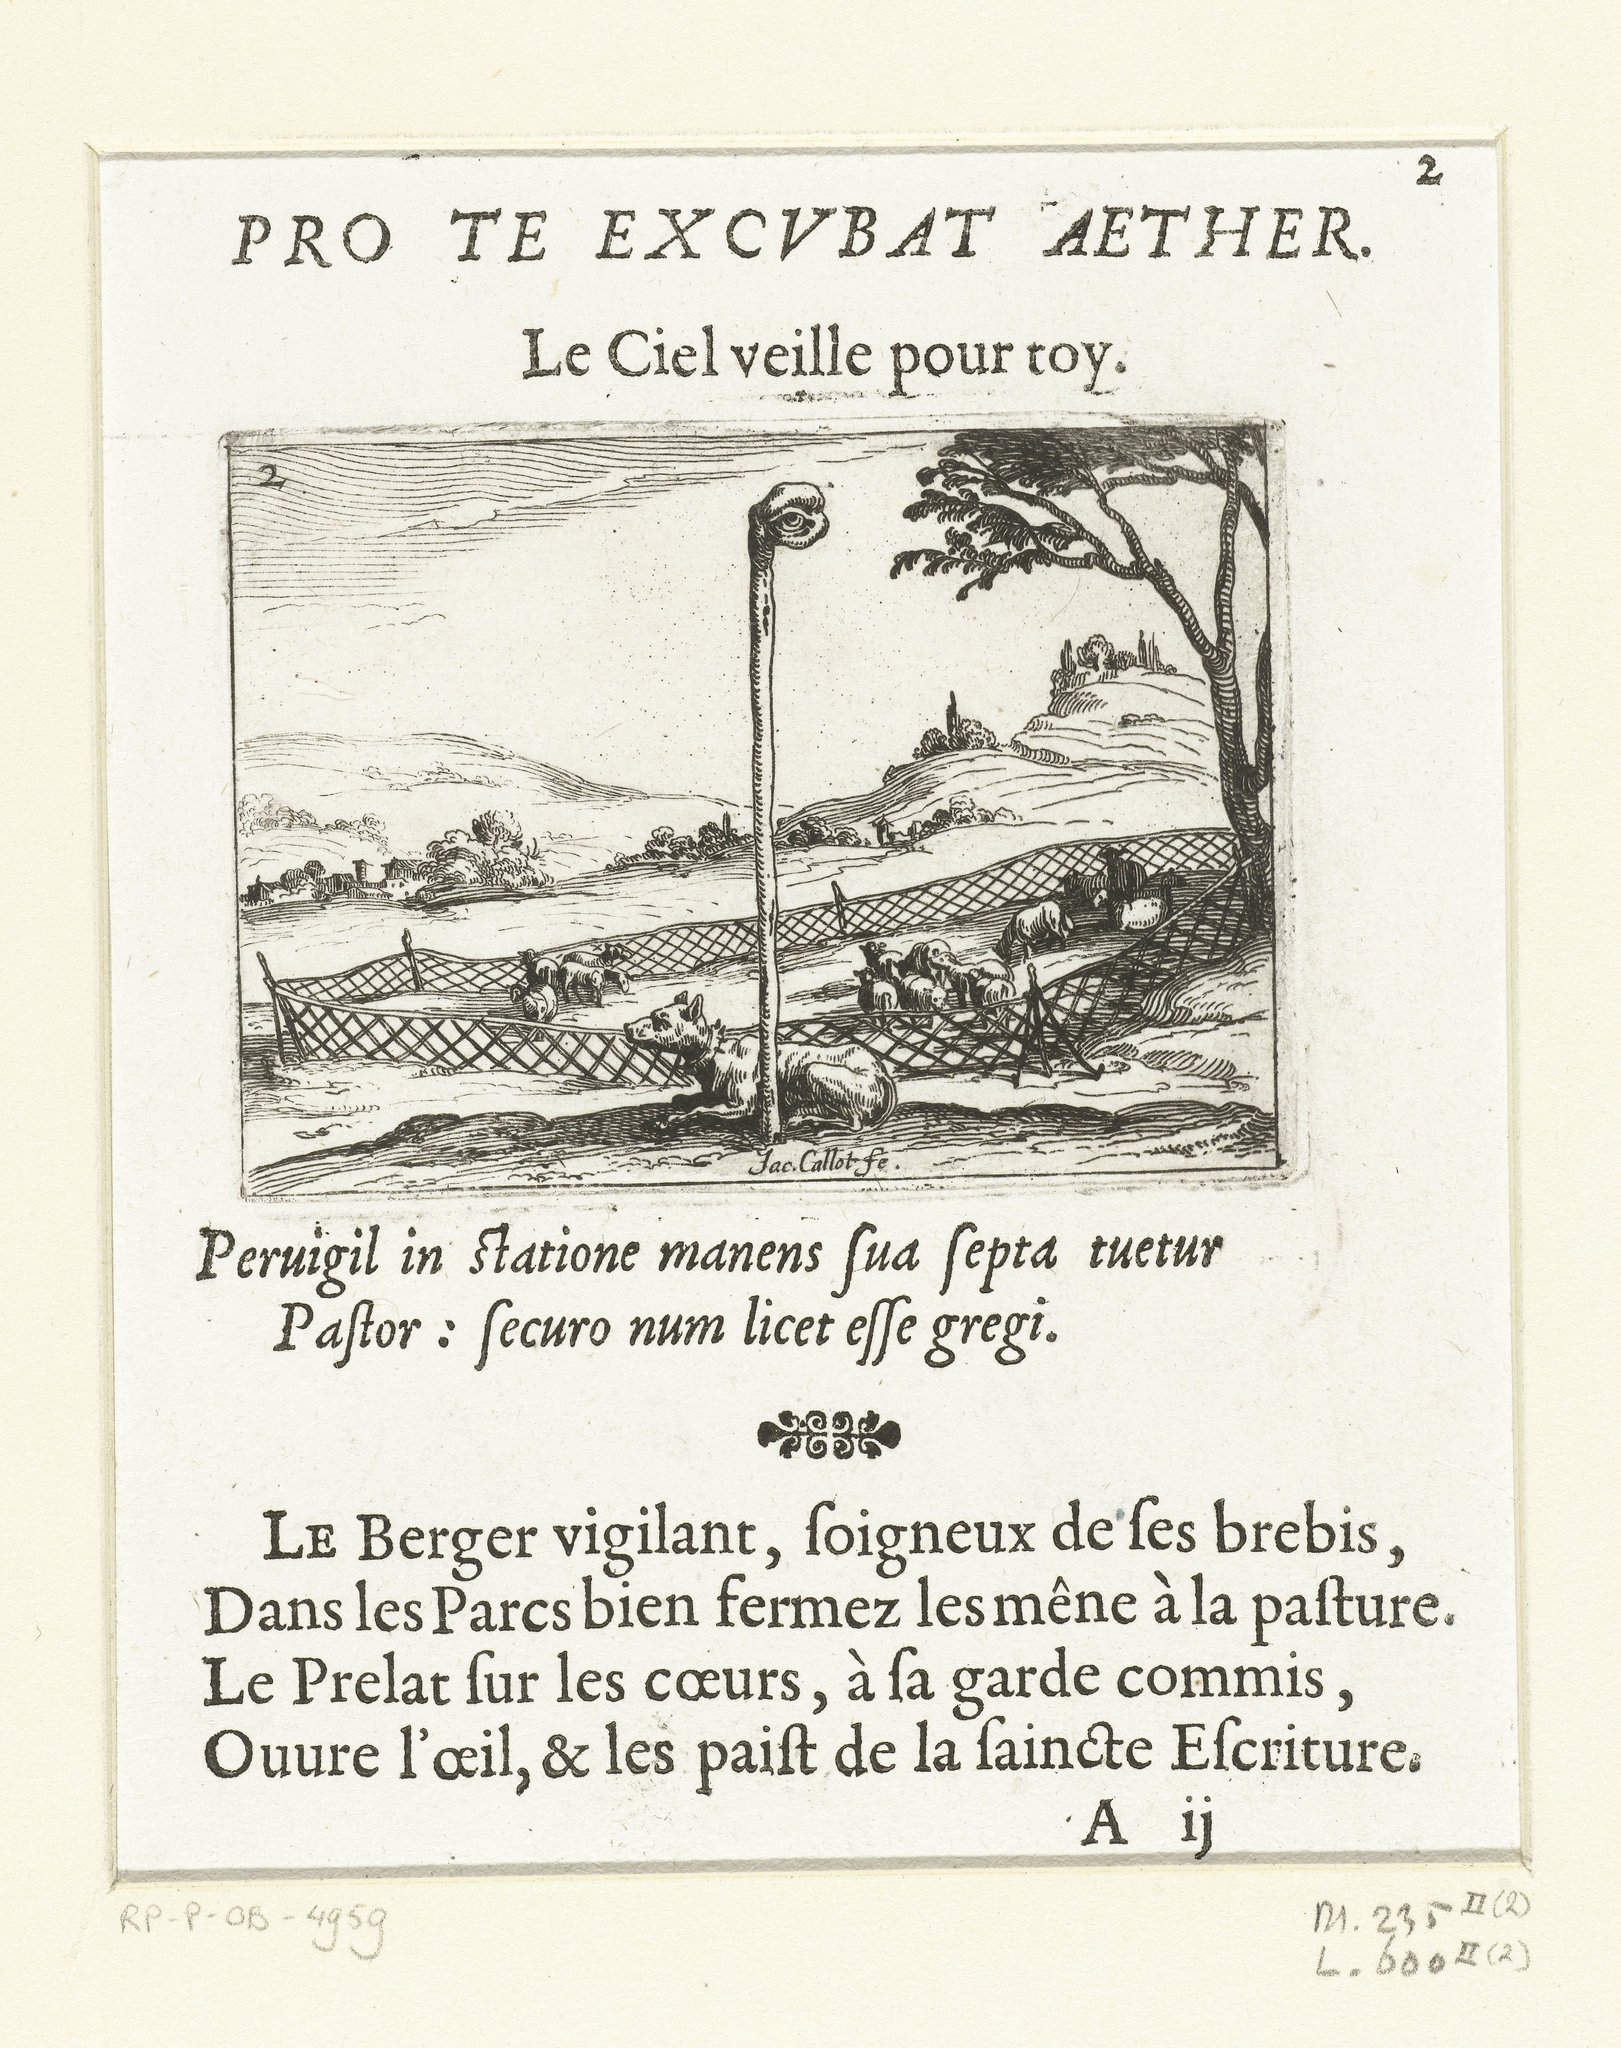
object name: cognizance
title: Kloosterleven in emblemen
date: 1621-1635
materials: paper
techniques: etching, letterpress printing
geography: nancy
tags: sheep, watch-dog, dog watching, eyes, herd, flock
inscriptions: collector's mark: Lugt 240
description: Voorstelling van een omheining waarbinnen schapen grazen; ernaast ligt een waakhond en staat een oog op een stok. Boven en onder deze prent Latijnse en Franse teksten in boekdruk. Dit blad is onderdeel van de embleemserie 'Kloosterleven in emblemen'. De tweede staat van deze serie behelst naast een geïllustreerde titelpagina en 26 emblemen nog een titelpagina en een blad met opdracht, beide in boekdruk zonder afbeelding.